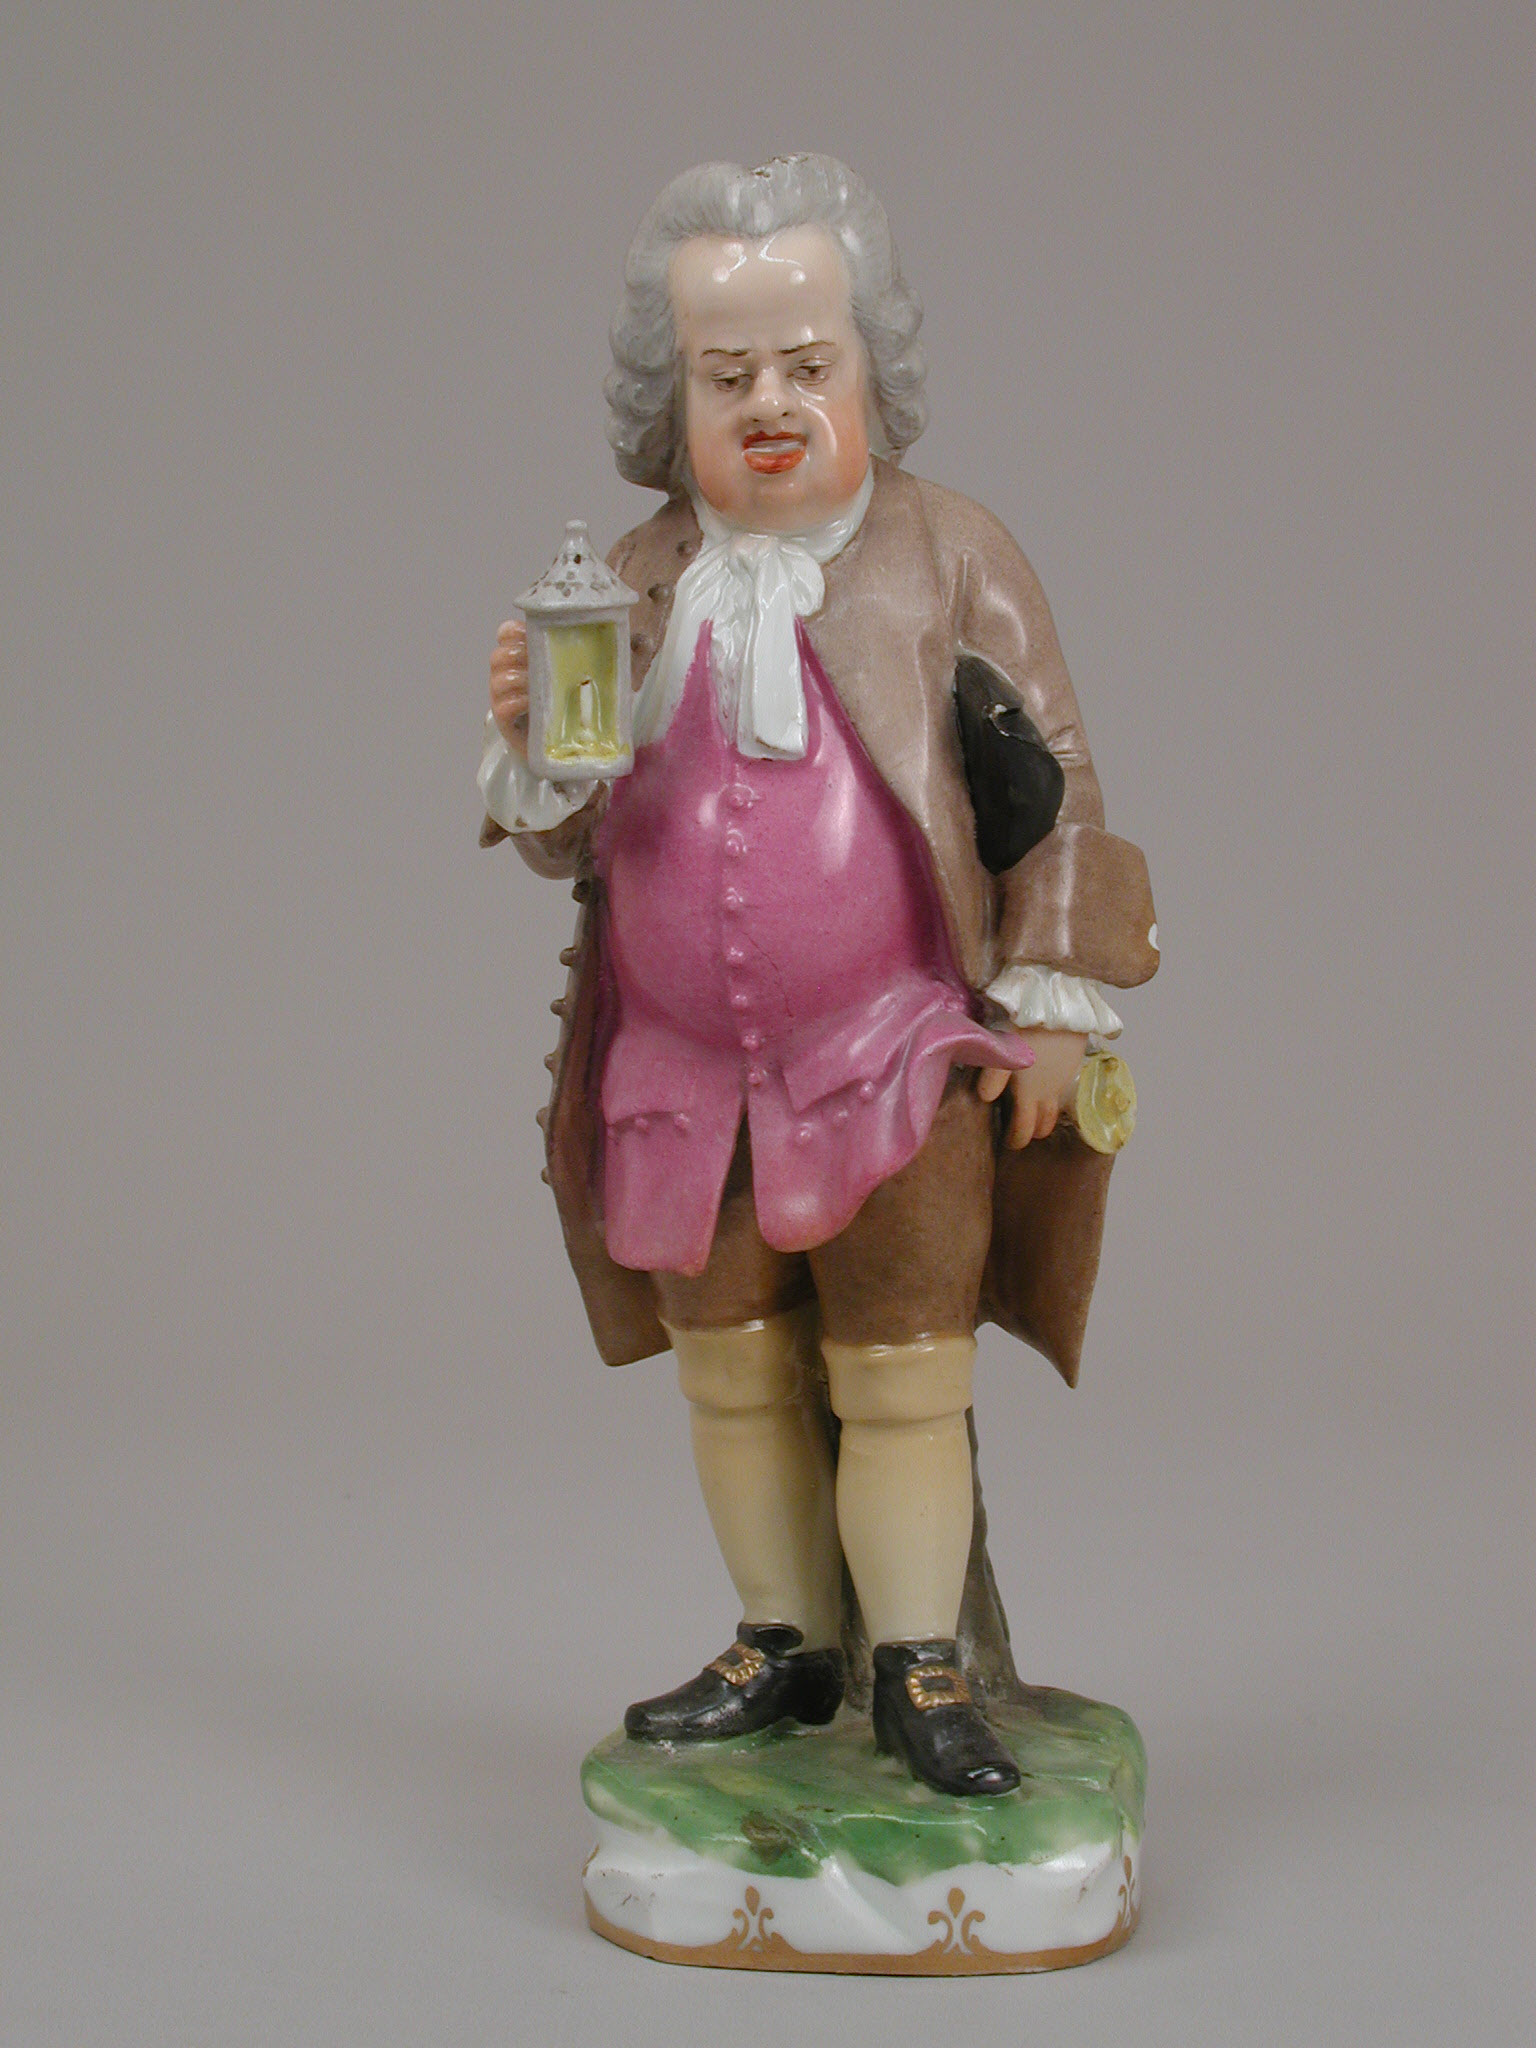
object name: figure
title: Burgomaster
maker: imperial porcelain manufactory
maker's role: manufactory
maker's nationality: austrian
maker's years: 1744-1864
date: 1765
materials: hard paste porcelain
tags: men,portraits